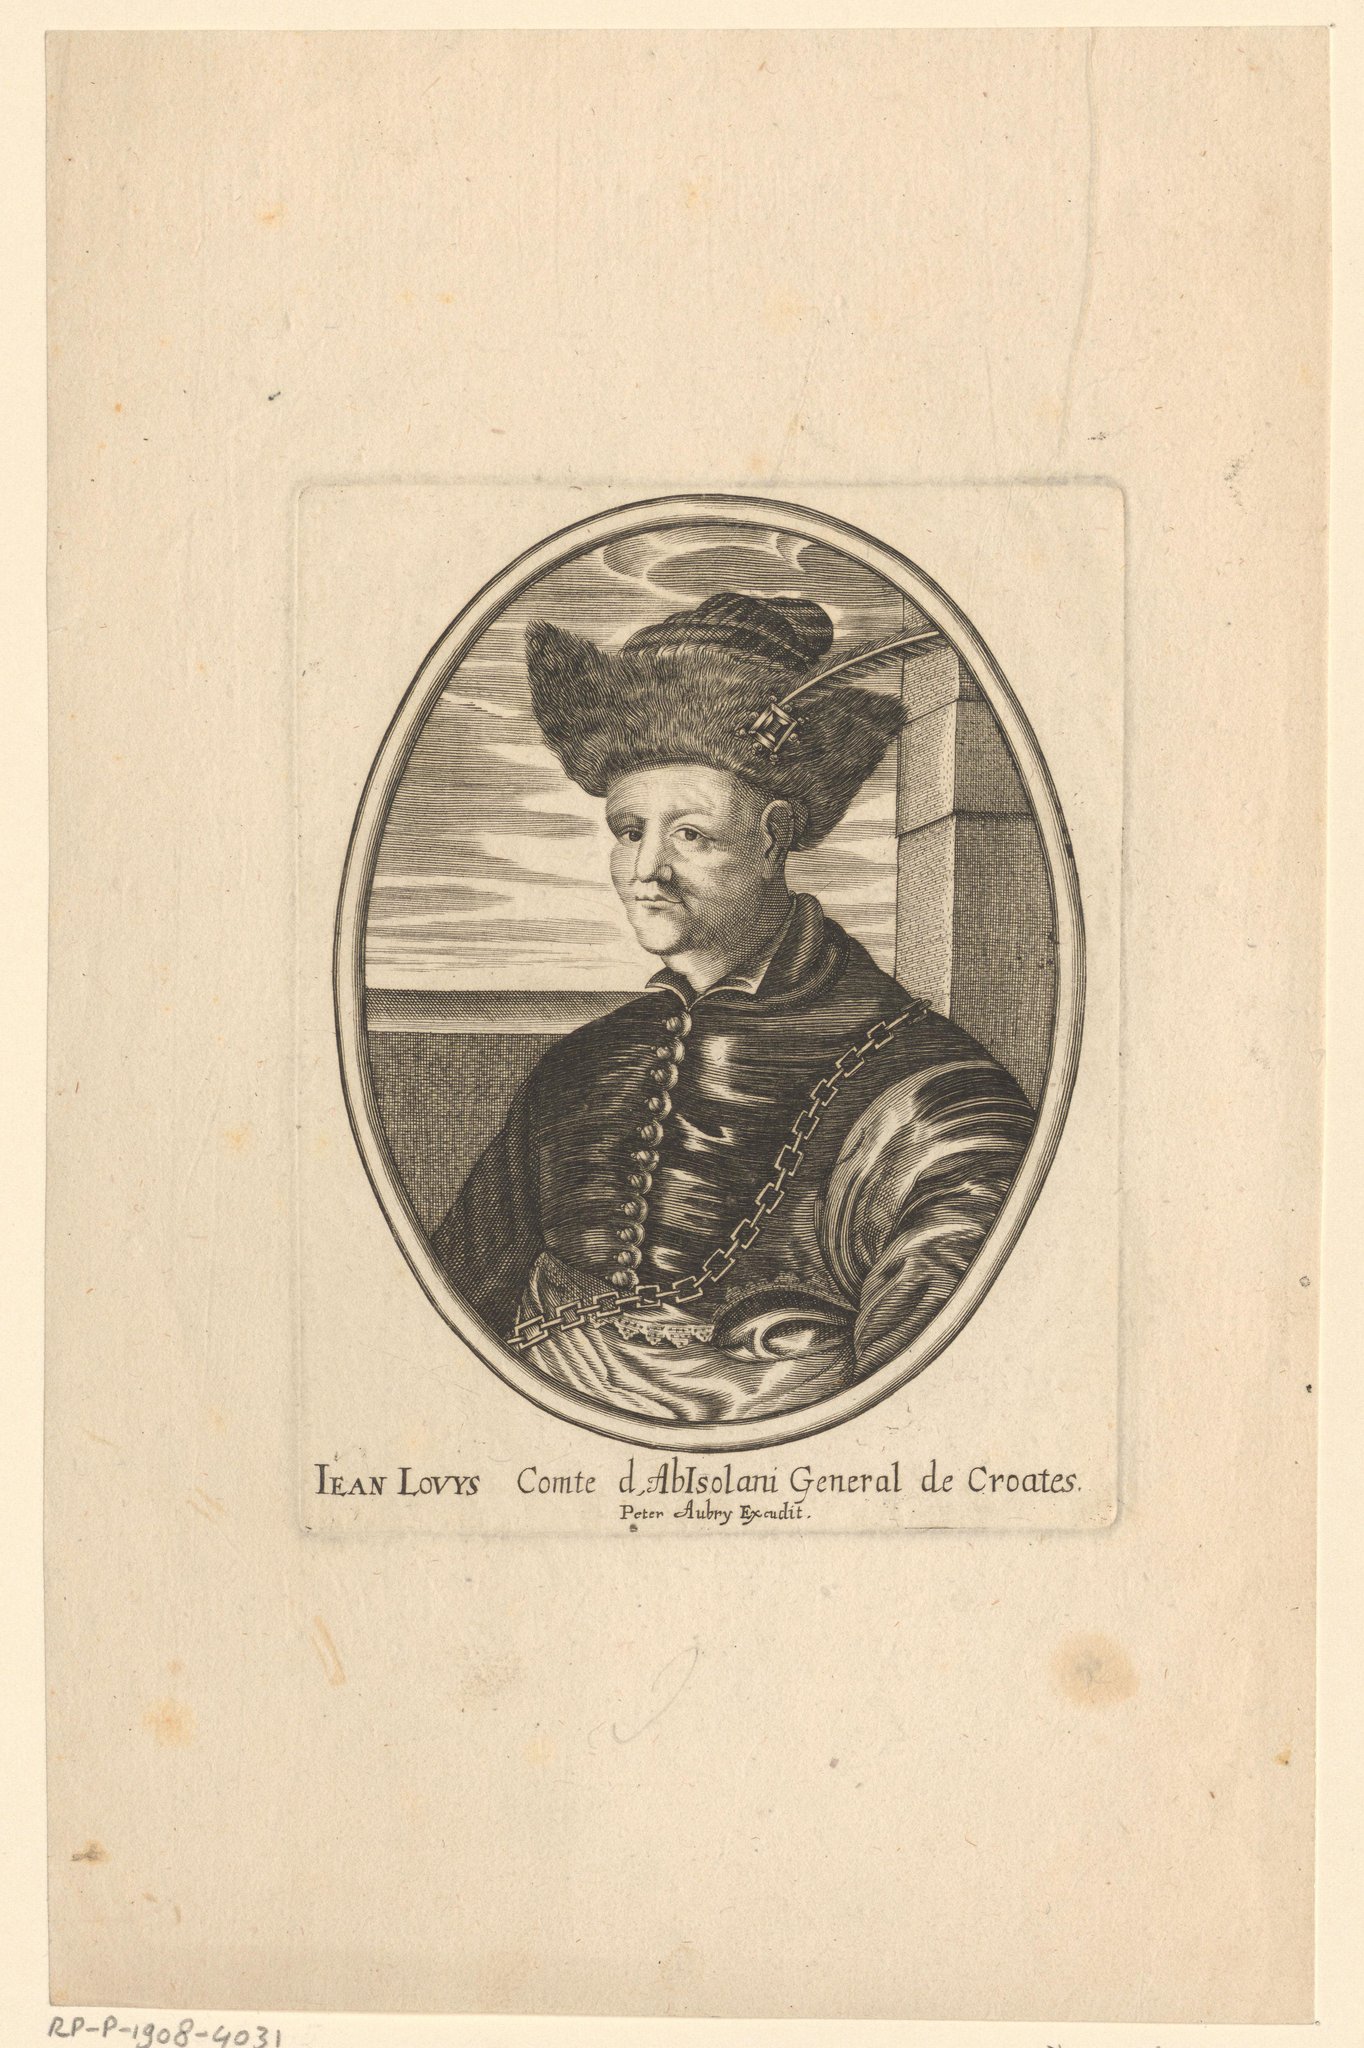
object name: print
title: Portret van Johann Ludwig Hector, graaf van Isolani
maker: Anonymous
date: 1606-1686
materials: paper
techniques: engraving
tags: vienna, earl, head-gear, commander-in-chief, general, marshal, historical persons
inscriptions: collector's mark: Lugt 2228